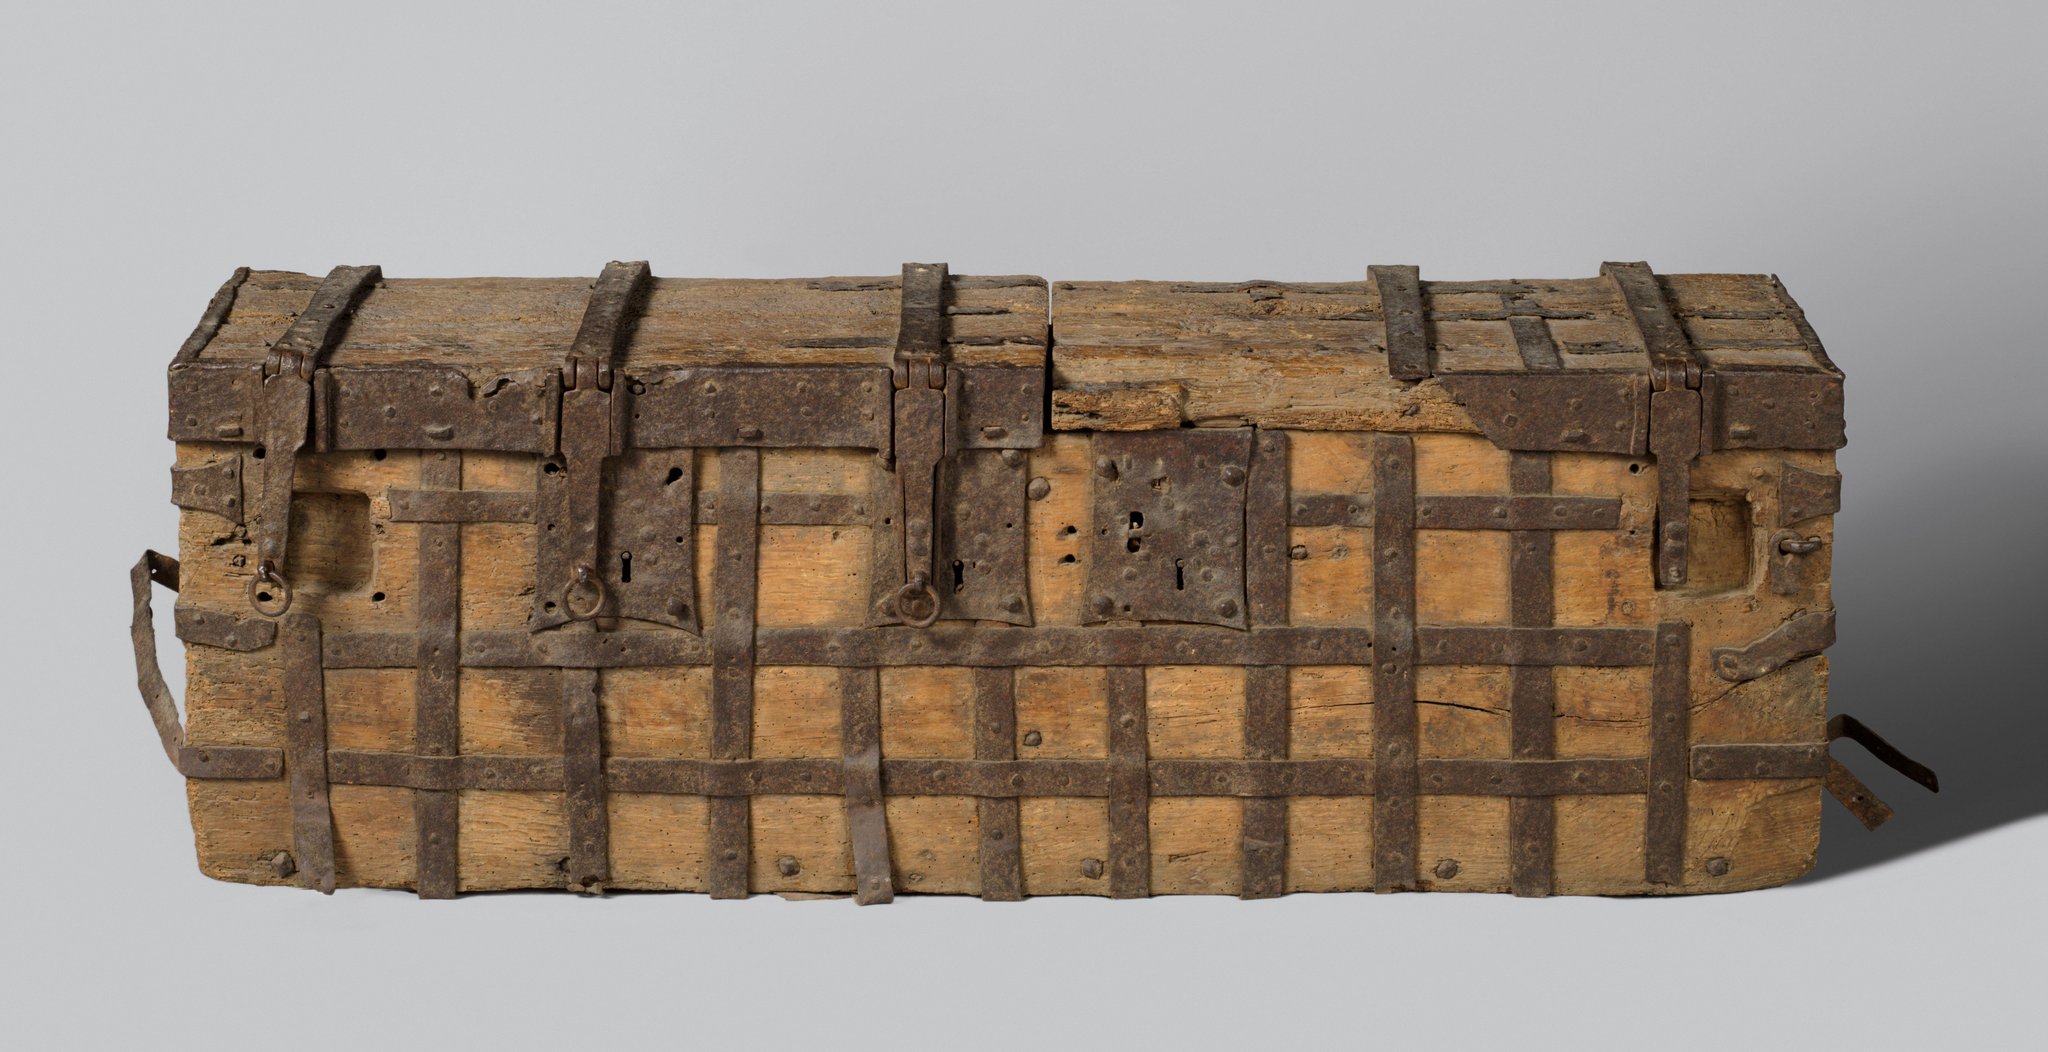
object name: furniture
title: Kist met twee naast elkaar geplaatste deksels en over het gehele oppervlad versierd met gesmede banden in een vierkant ruitpatroon, trekvallen en slotplaten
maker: Anonymous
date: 1400-1500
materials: iron, wood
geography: northern netherlands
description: Houten kist met twee naast elkaar geplaatste deksels en over het gehele oppervlak versierd met gesmede banden in een vierkant ruitpatroon. Op één deksel zijn drie overvallen met een trekring en op de andere deksel twee overvallen aangebracht (waarvan er één ontbreekt) die corresponderen met een slotplaat. De twee buitenste slotplaten zijn niet meer aanwezig.